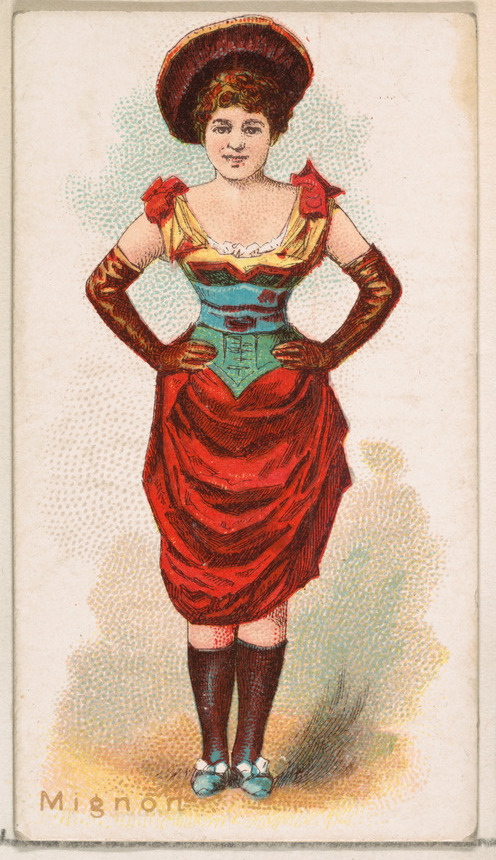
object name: print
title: Mignon, from the Ballet Queens series (N182) issued by Wm. S. Kimball & Co.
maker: william s. kimball & company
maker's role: publisher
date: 1889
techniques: color lithograph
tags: women